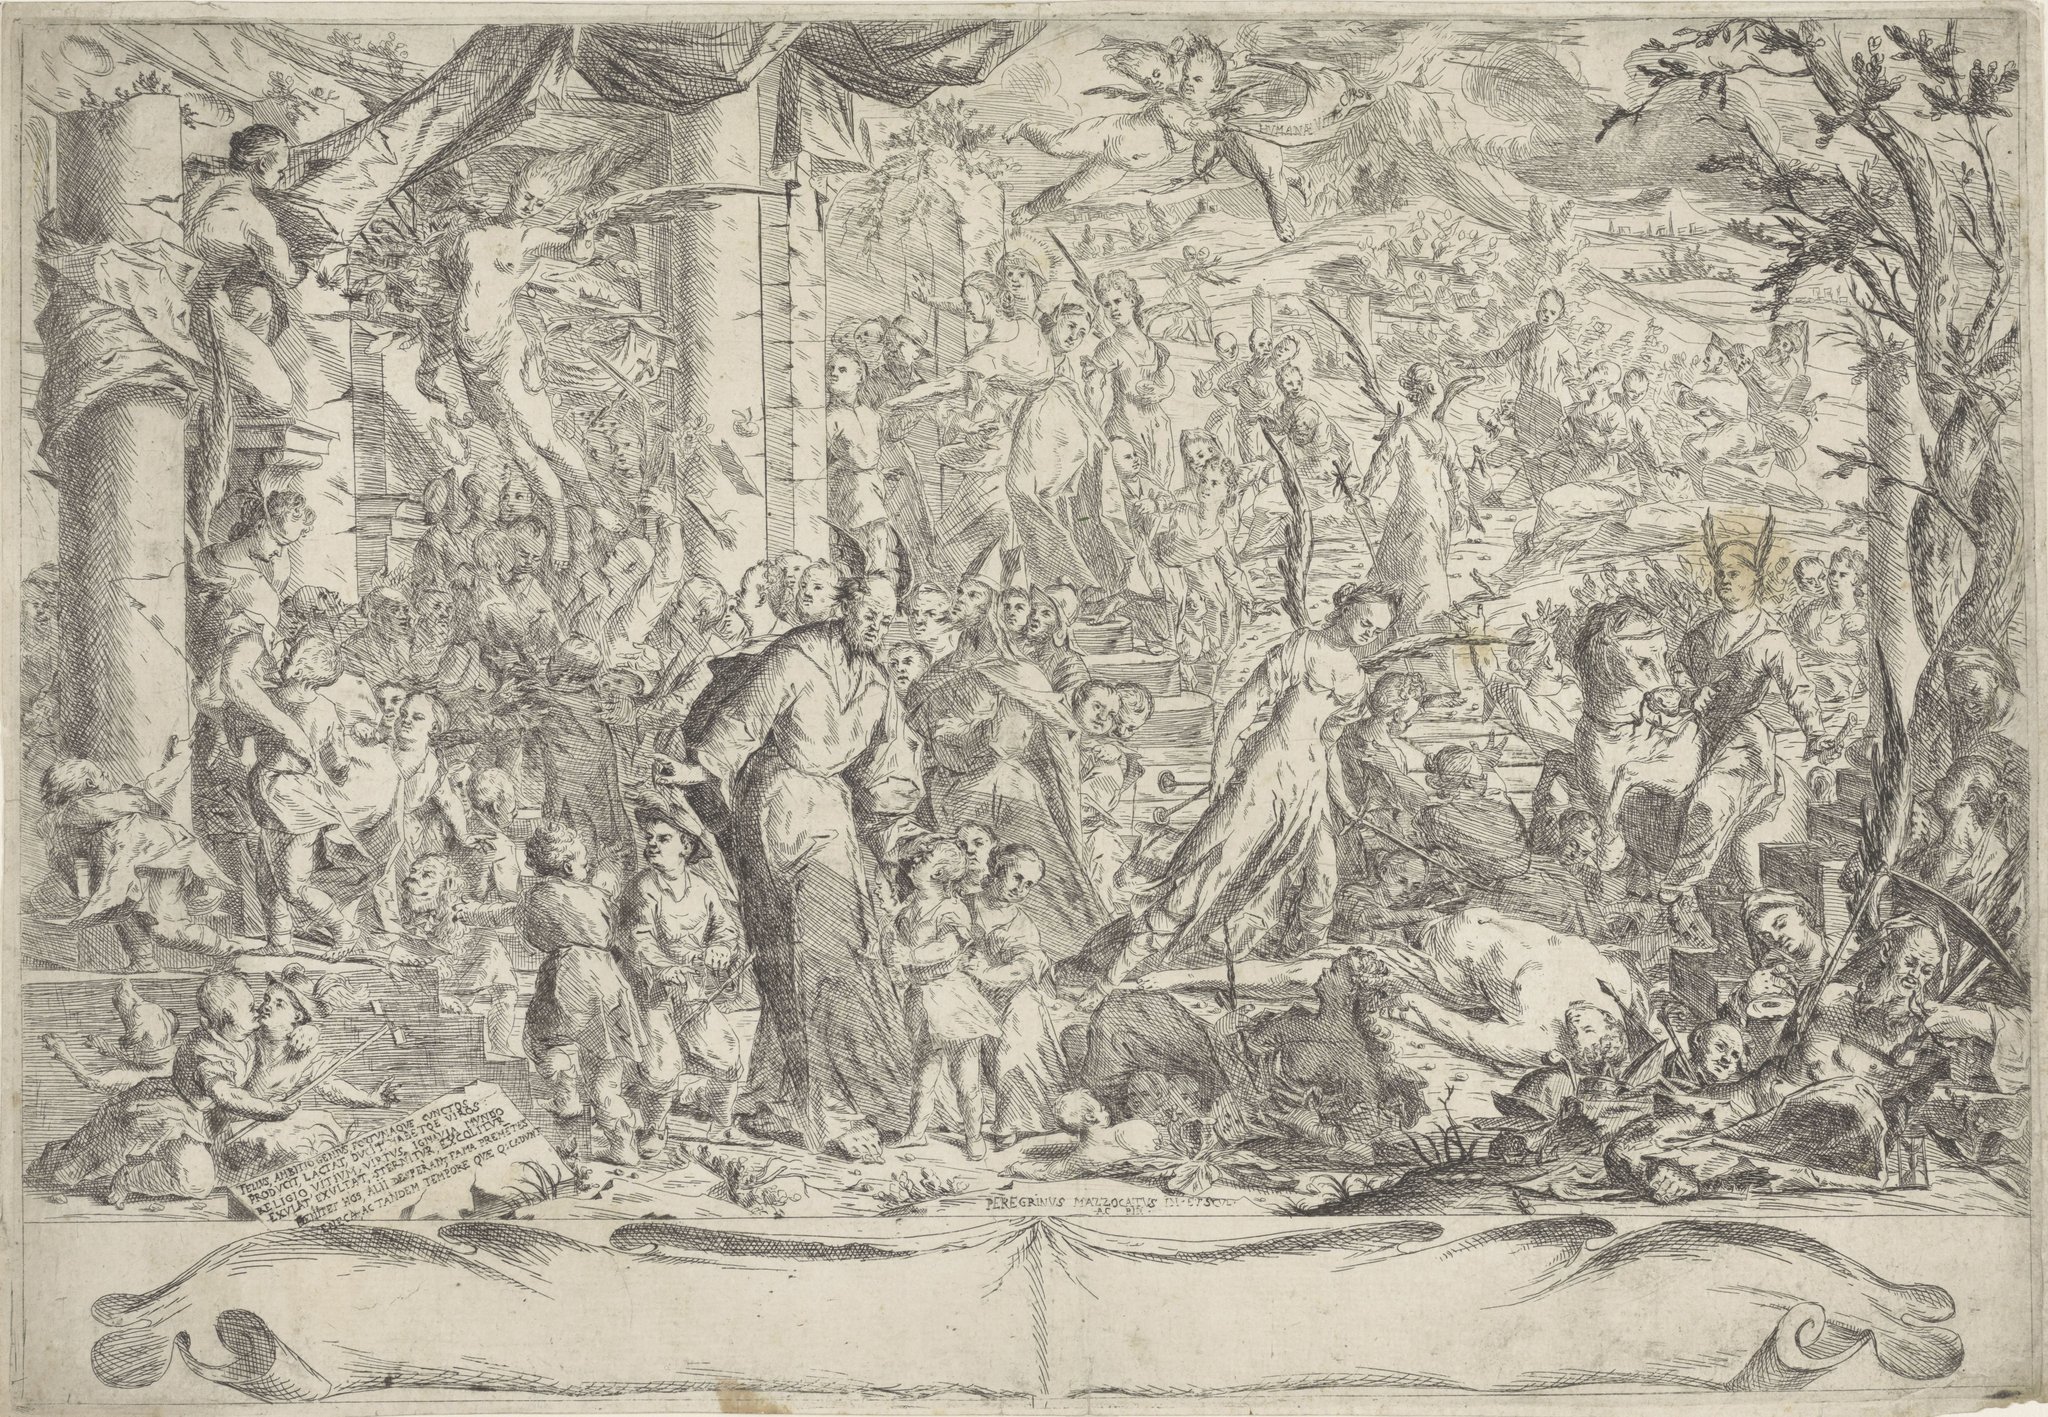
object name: print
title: Allegorie op het menselijk leven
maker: peregrino mazzocati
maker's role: print maker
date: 1645-1655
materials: paper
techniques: etching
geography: italy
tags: life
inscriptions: collector's mark: Lugt 2760, number: ‘No. 5-5’, collector's mark: Lugt 2228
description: Allegorie op het menselijk leven. Een menigte allegorische figuren voor de ruïnes van een gebouw. Leeg cartouche in ondermarge.